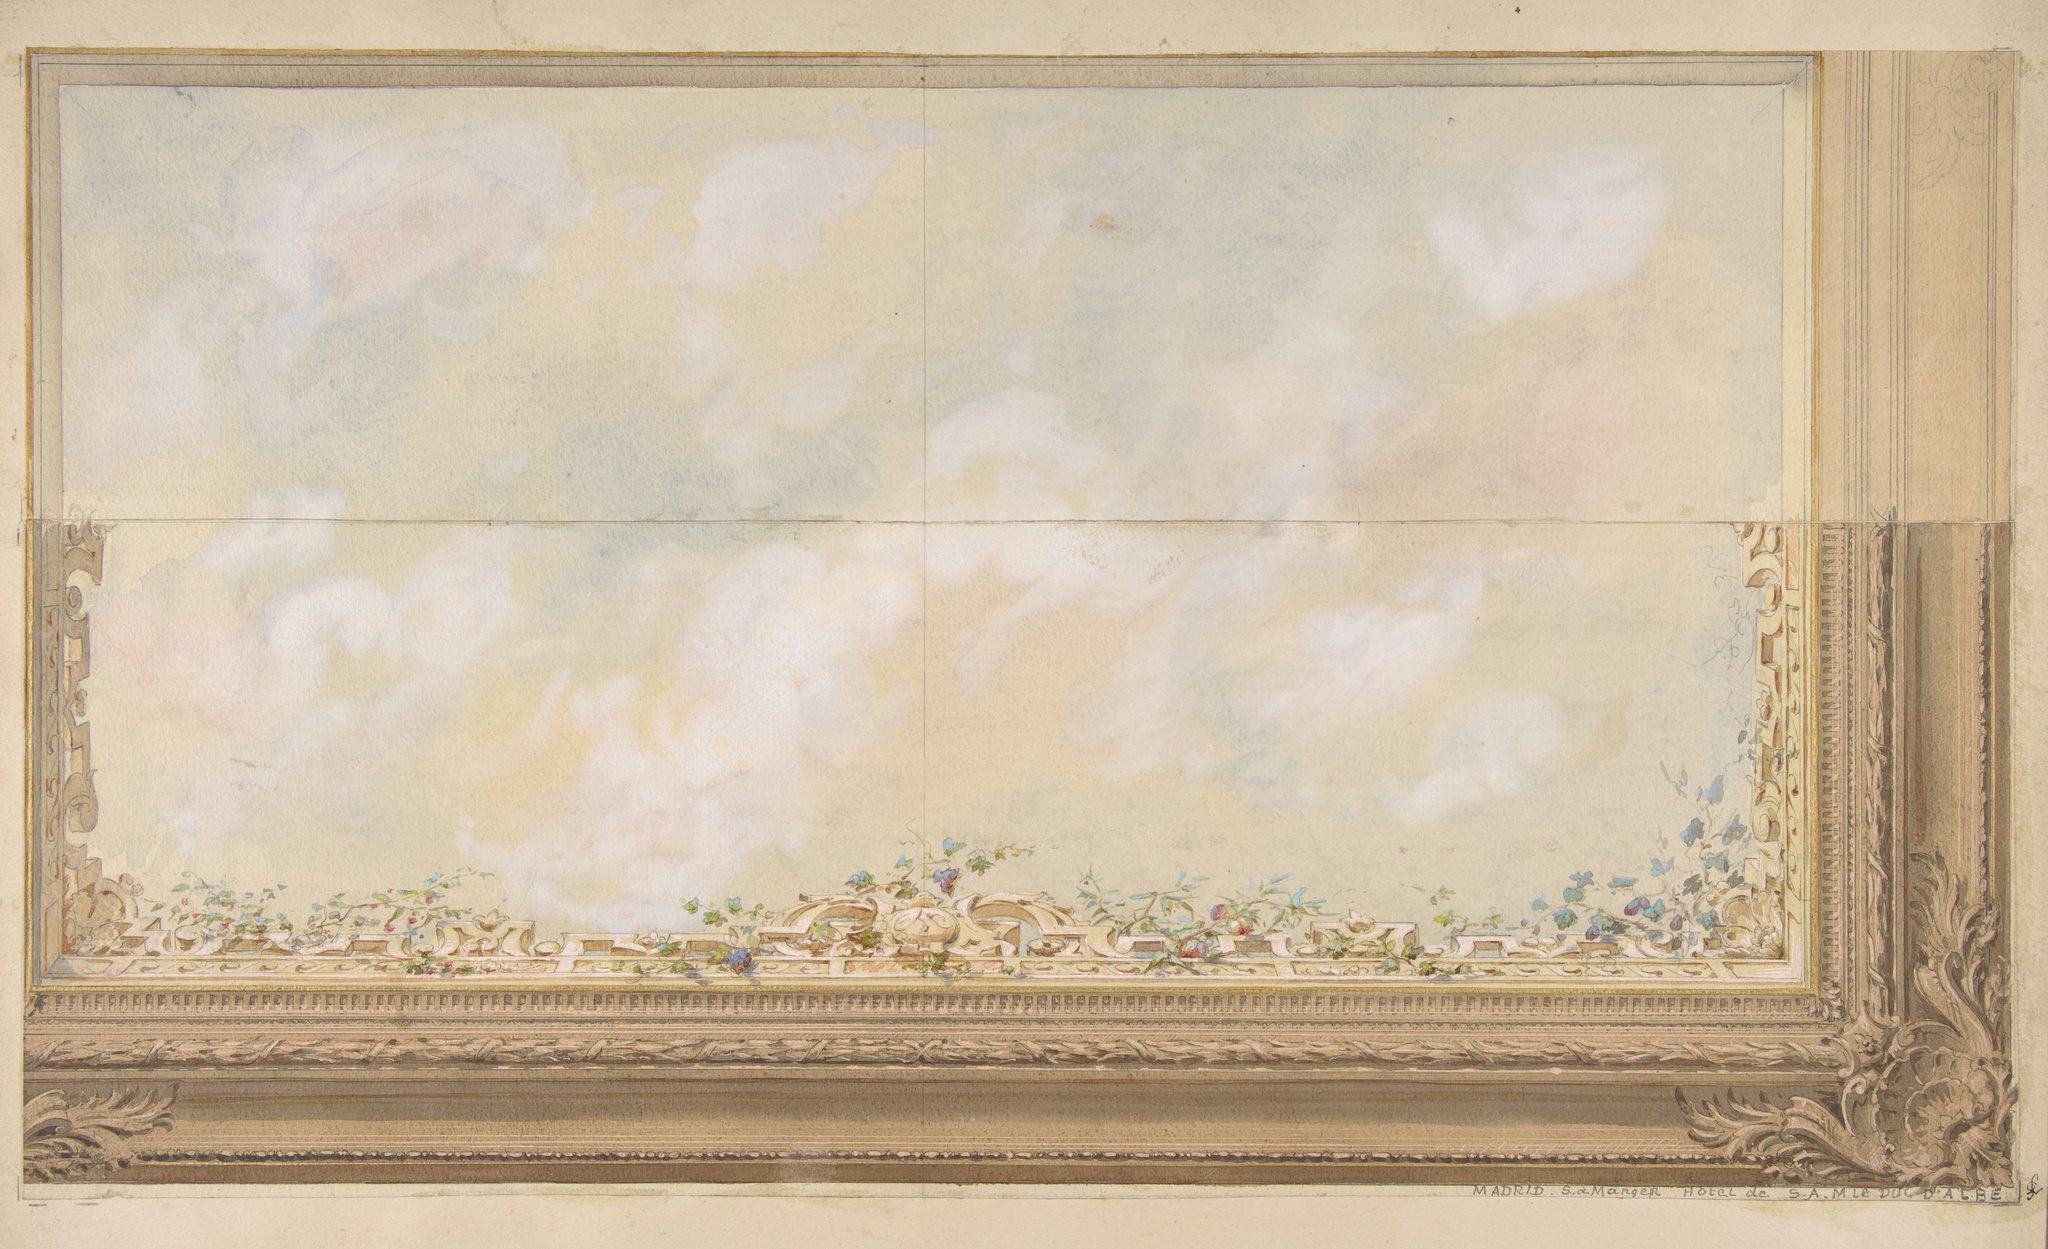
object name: drawing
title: Ceiling Design for the Dining Room of the Duke d'Albe, Madrid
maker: jules-edmond-charles lachaise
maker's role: artist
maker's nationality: french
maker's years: 1897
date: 1851-1900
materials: gilt, graphite, ink, watercolor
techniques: brush, pen, wash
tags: ceilings